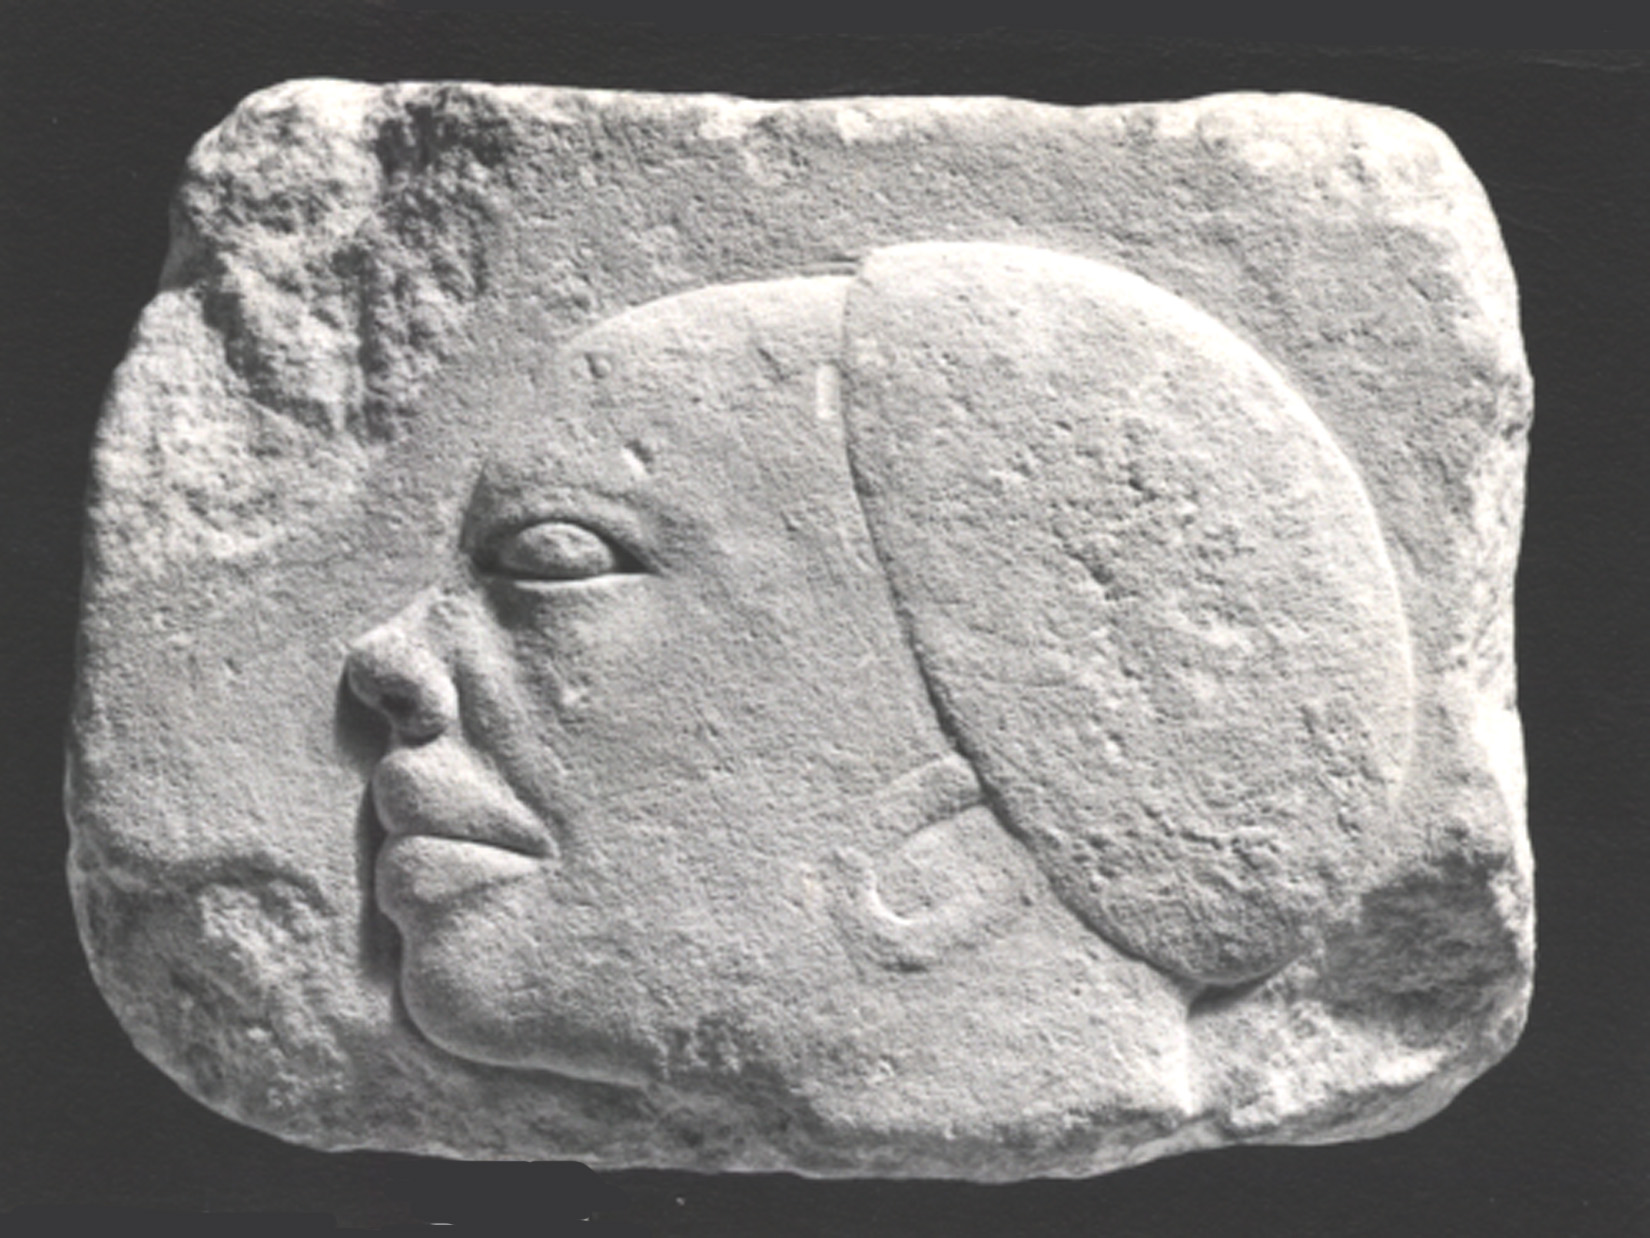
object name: relief, head of nubian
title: Relief with a head of a Nubian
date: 1550-1295 BCE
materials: stone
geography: egypt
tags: human figures,heads